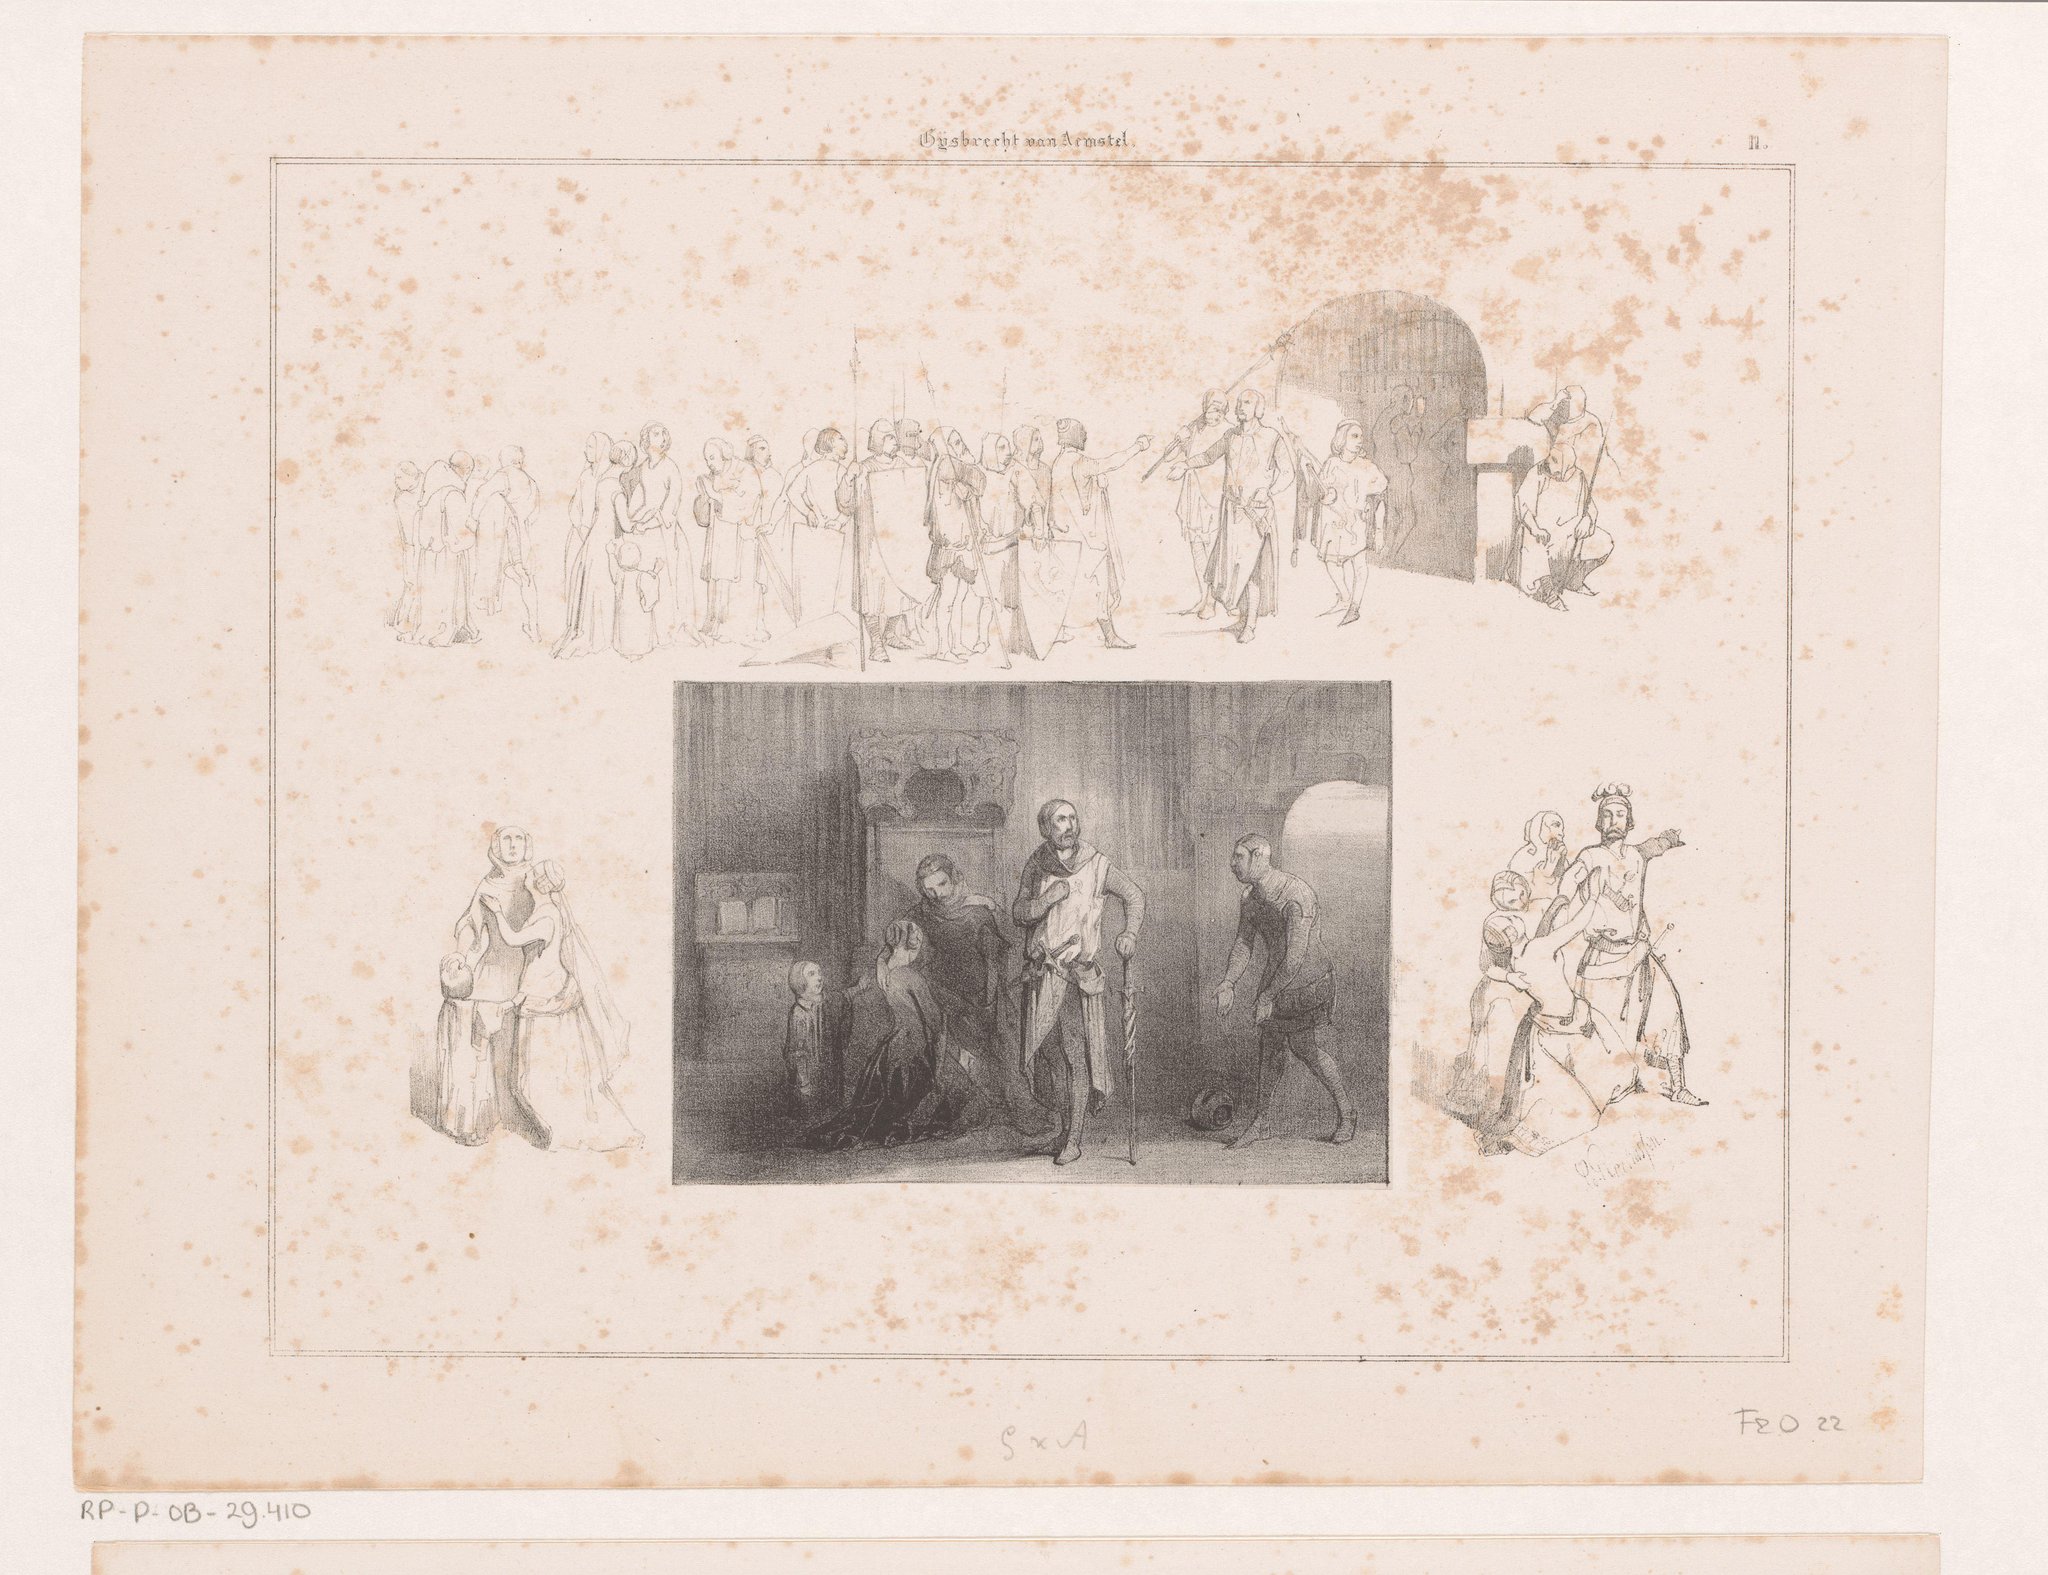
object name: book illustration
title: Geharnaste man met twee vrouwen en kind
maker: charles rochussen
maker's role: draughtsman, painter, print maker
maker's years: 1814-1894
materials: paper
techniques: lithograph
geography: the hague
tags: adult woman, knight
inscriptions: collector's mark: Lugt 2228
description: Een geharnast man staat in een interieur bij twee vrouwen en een kind. Rechts komt een ridder aanlopen. Rondom diverse scènes met ridders, monniken en treurende of smekende vrouwen.